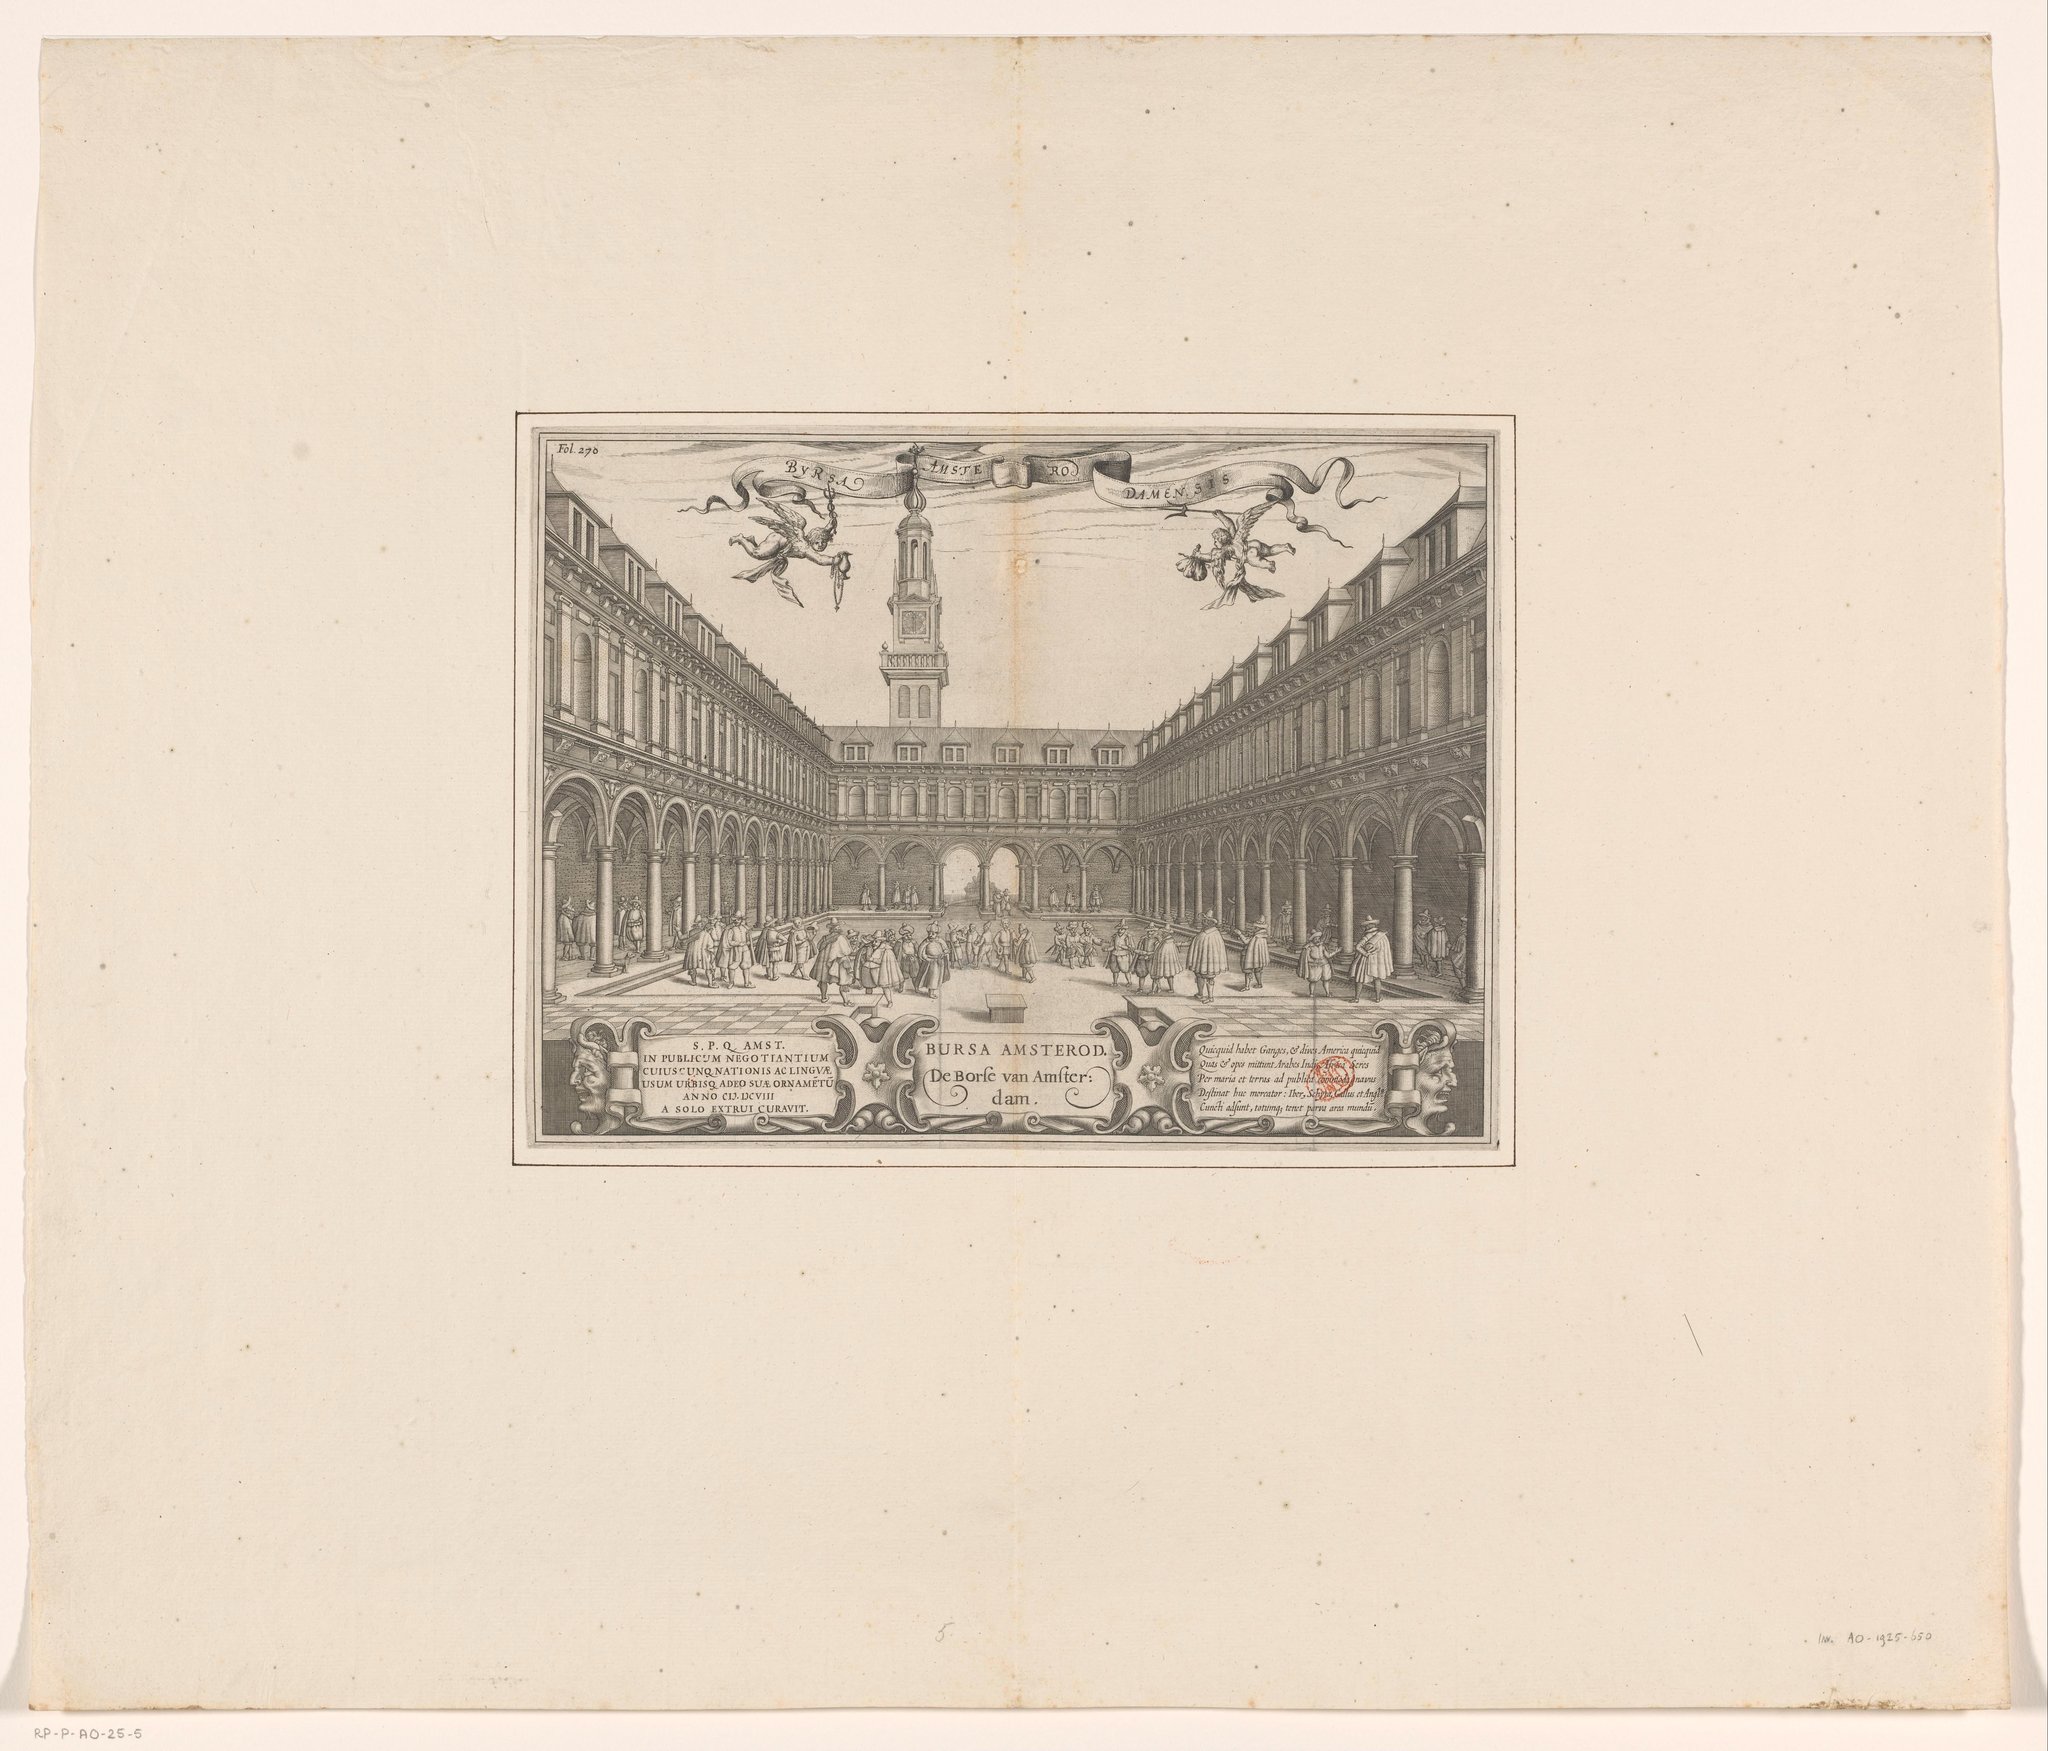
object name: book illustration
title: Gezicht op de binnenplaats van de Beurs van Hendrik de Keyser te Amsterdam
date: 1614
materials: paper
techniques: engraving, etching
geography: amsterdam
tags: purse, money-bag, courtyard, attributes of neptune: trident, caduceus (staff with two snakes, attribute of mercury), exchange, bourse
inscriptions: collector's mark: Lugt 195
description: Gezicht op de binnenplaats van de Beurs van Hendrik de Keyser. Op het plein verschillende figuren, waaronder kooplieden met tulbanden. Onder een cartouche met in het midden de titel, links een zesregelig opschrift en rechts een vijfregelig vers in het Latijn. Boven in het midden een banderol met een tweede titel. Daaronder links een putto met een caduceus en kostbaarheden en rechts een putto met een geldbeurs en een drietand. Linksboven genummerd: Fol. 270.